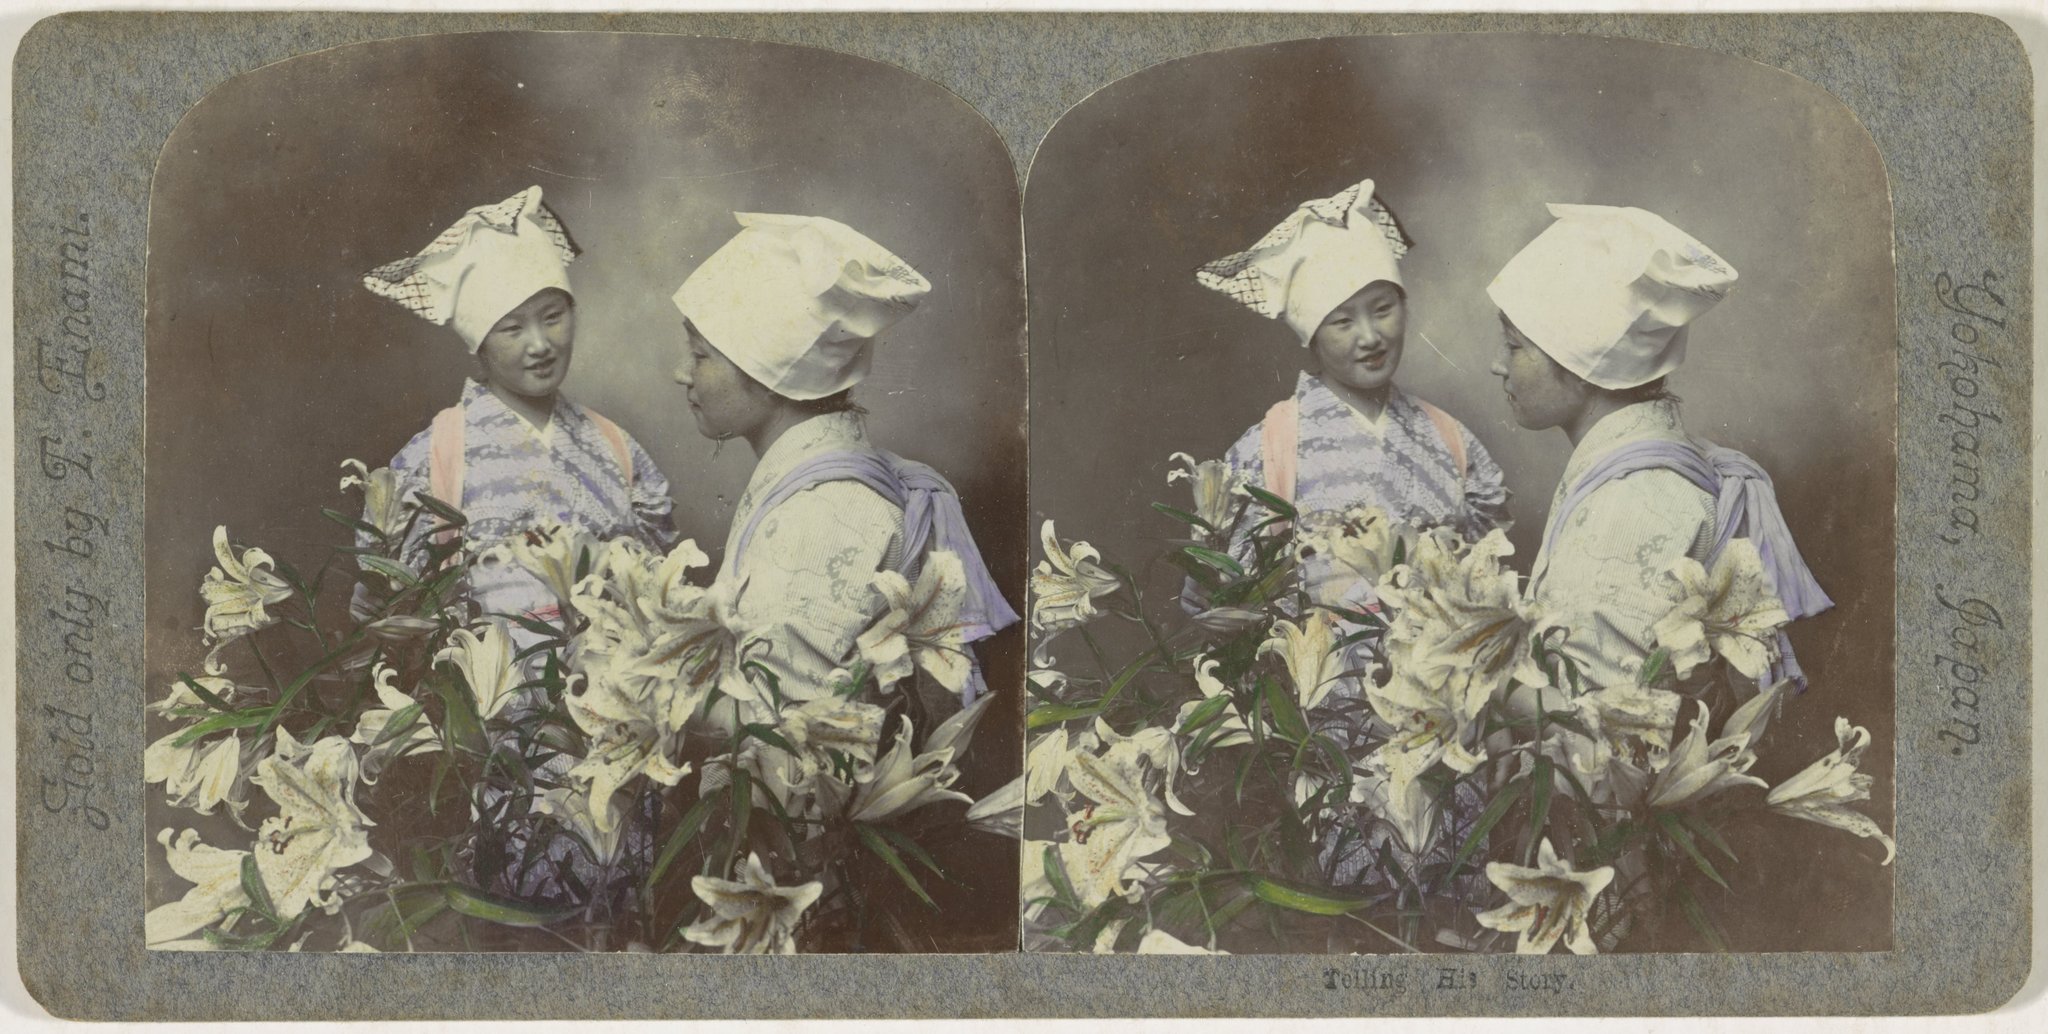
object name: stereograph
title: Telling His Story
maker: t. enami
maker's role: publisher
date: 1900-1907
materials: paper, cardboard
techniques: hand coloring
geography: yokohama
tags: speaking, flowers: lily, japan